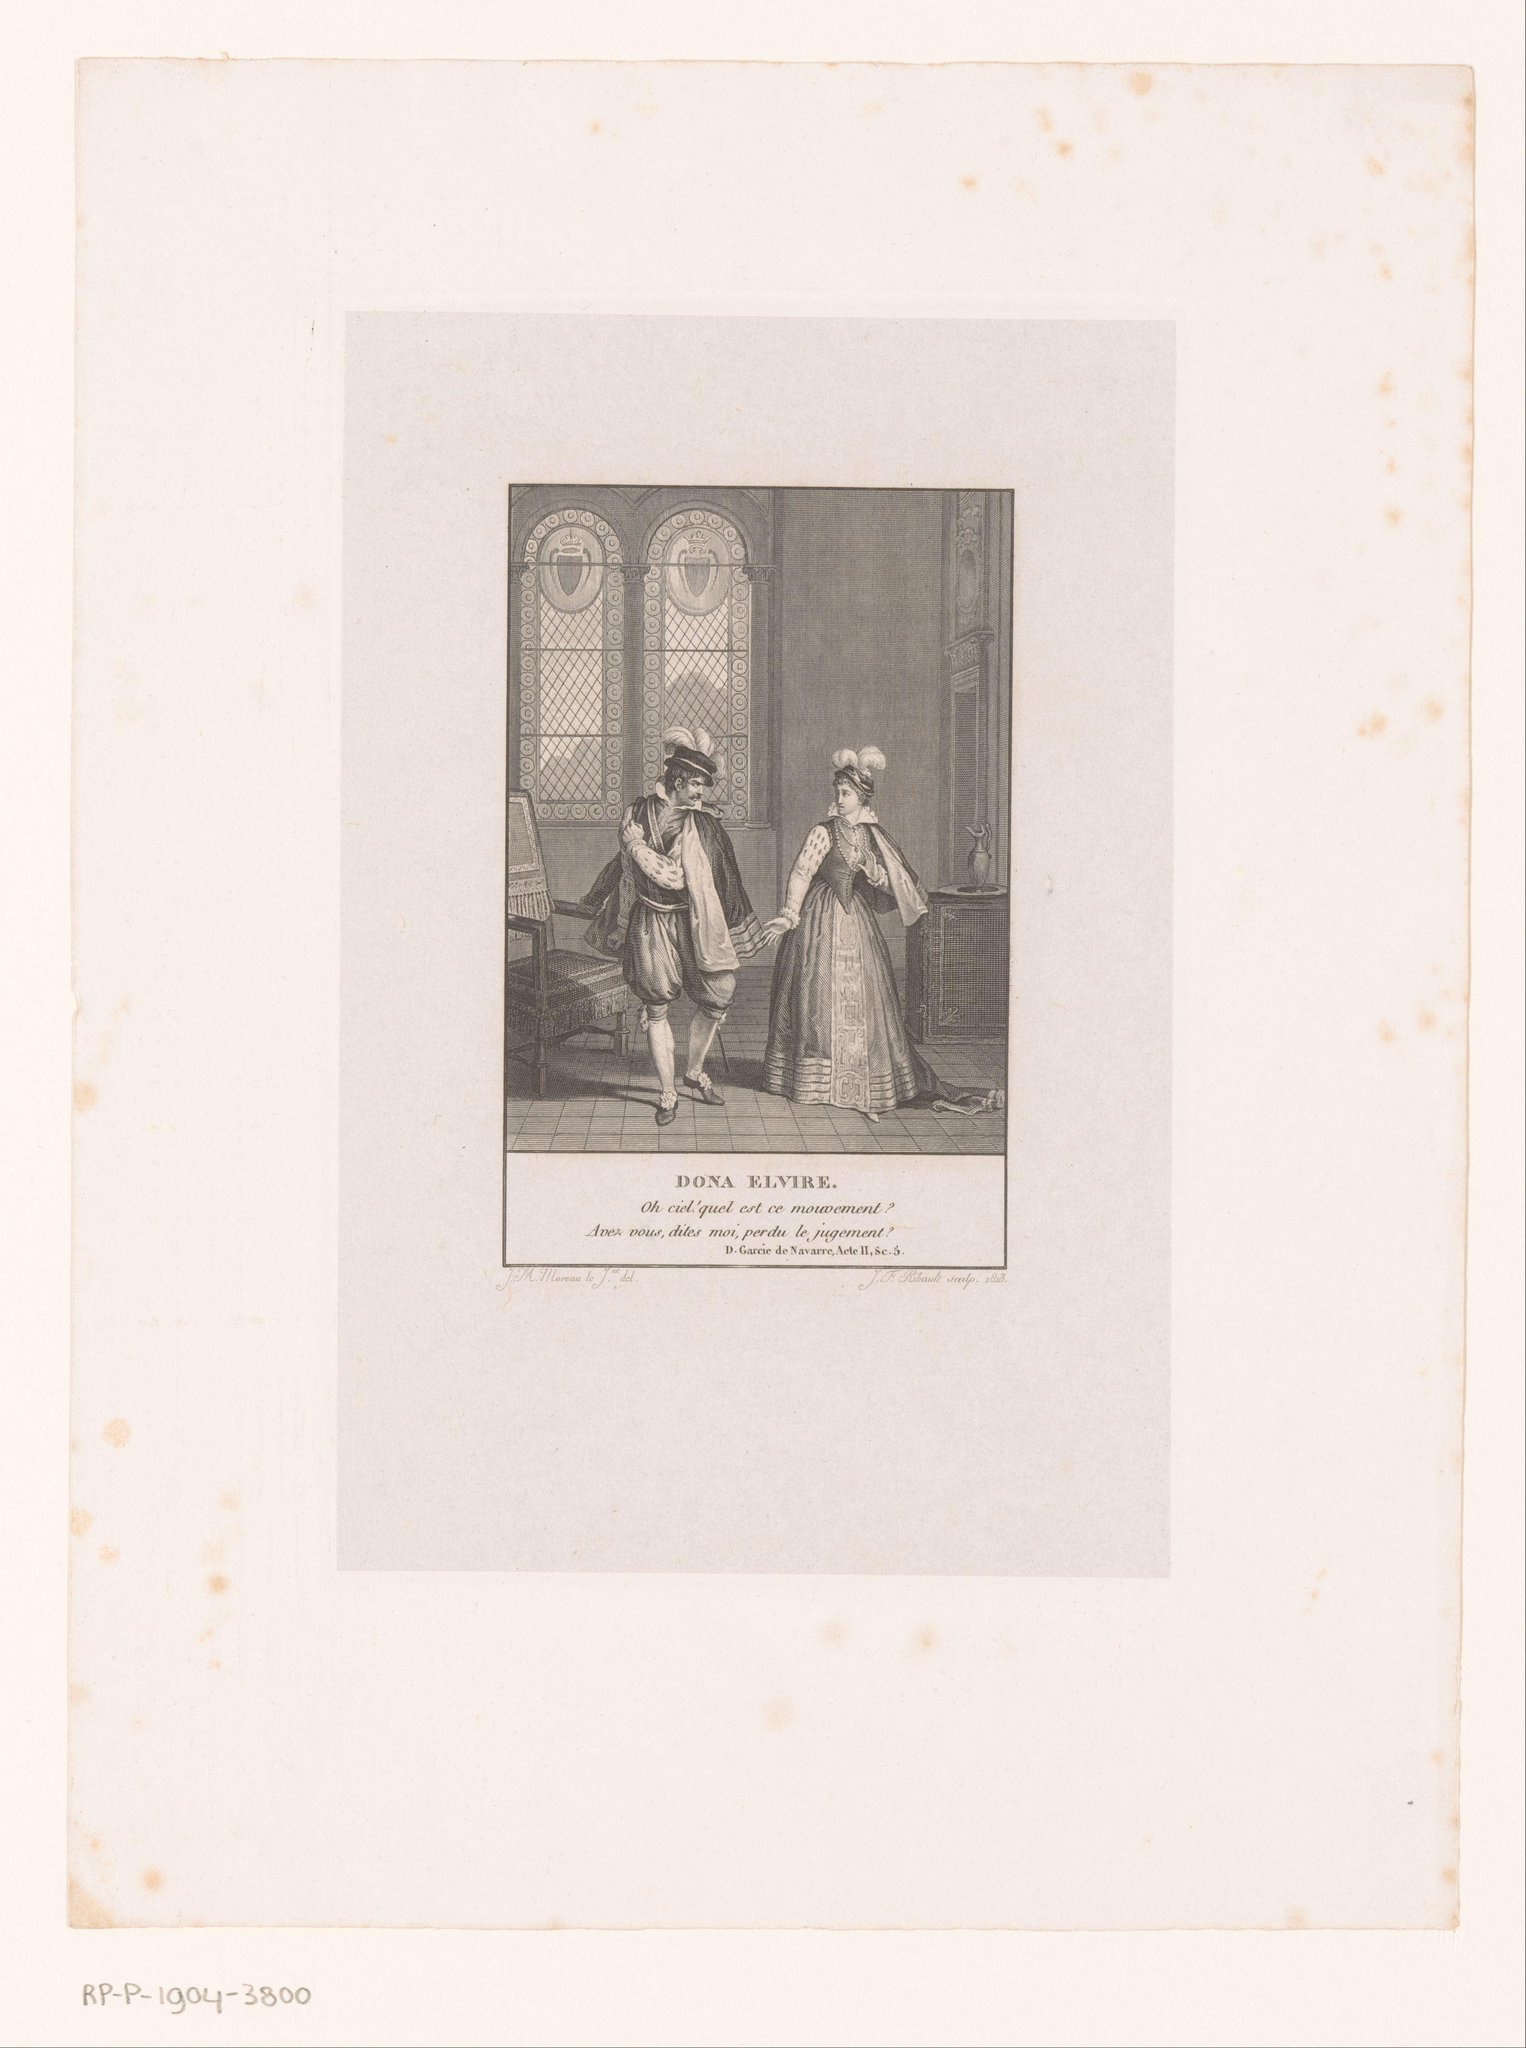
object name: print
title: Interieur met edelman die boos kijkt naar een dame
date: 1813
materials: paper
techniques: engraving, etching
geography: paris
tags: theatre, theatrical performance, aggressive relationships, enmity, animosity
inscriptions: collector's mark: Lugt 2228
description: Prent van scène vijf uit de tweede acte uit 'Dom Garcie de Navarre' door Jean Baptiste Molière. Dit betreft één van de dertig prenten, gemaakt in opdracht van Antoine Augustin Renouard, bestemd voor verschillende edities van Molières werk daterend van 1811 tot 1813. De prenten zijn vervaardigd door verschillende kunstenaars naar composities van Moreau.